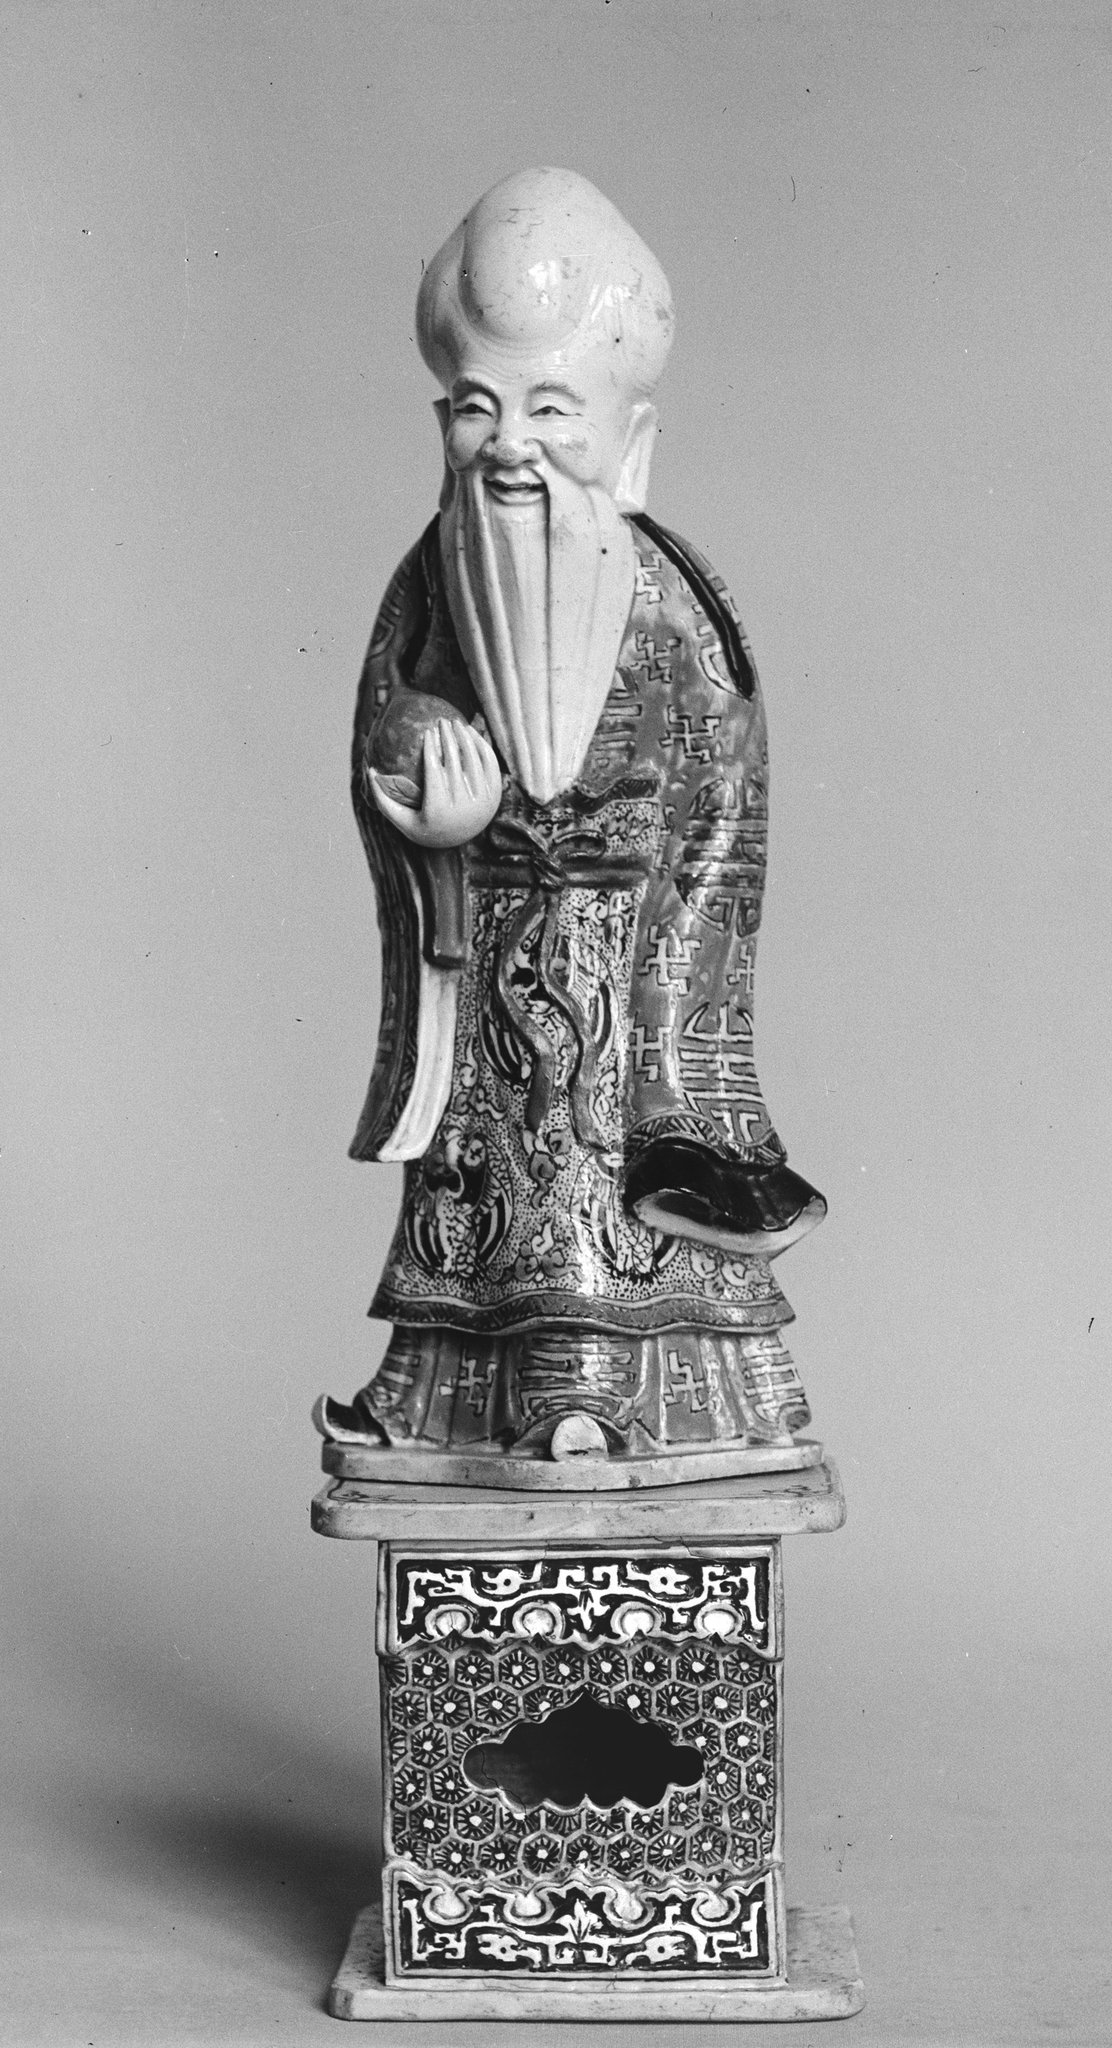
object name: figure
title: Shoulao, God of Longevity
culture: chinese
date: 1736-1795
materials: porcelain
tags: gods